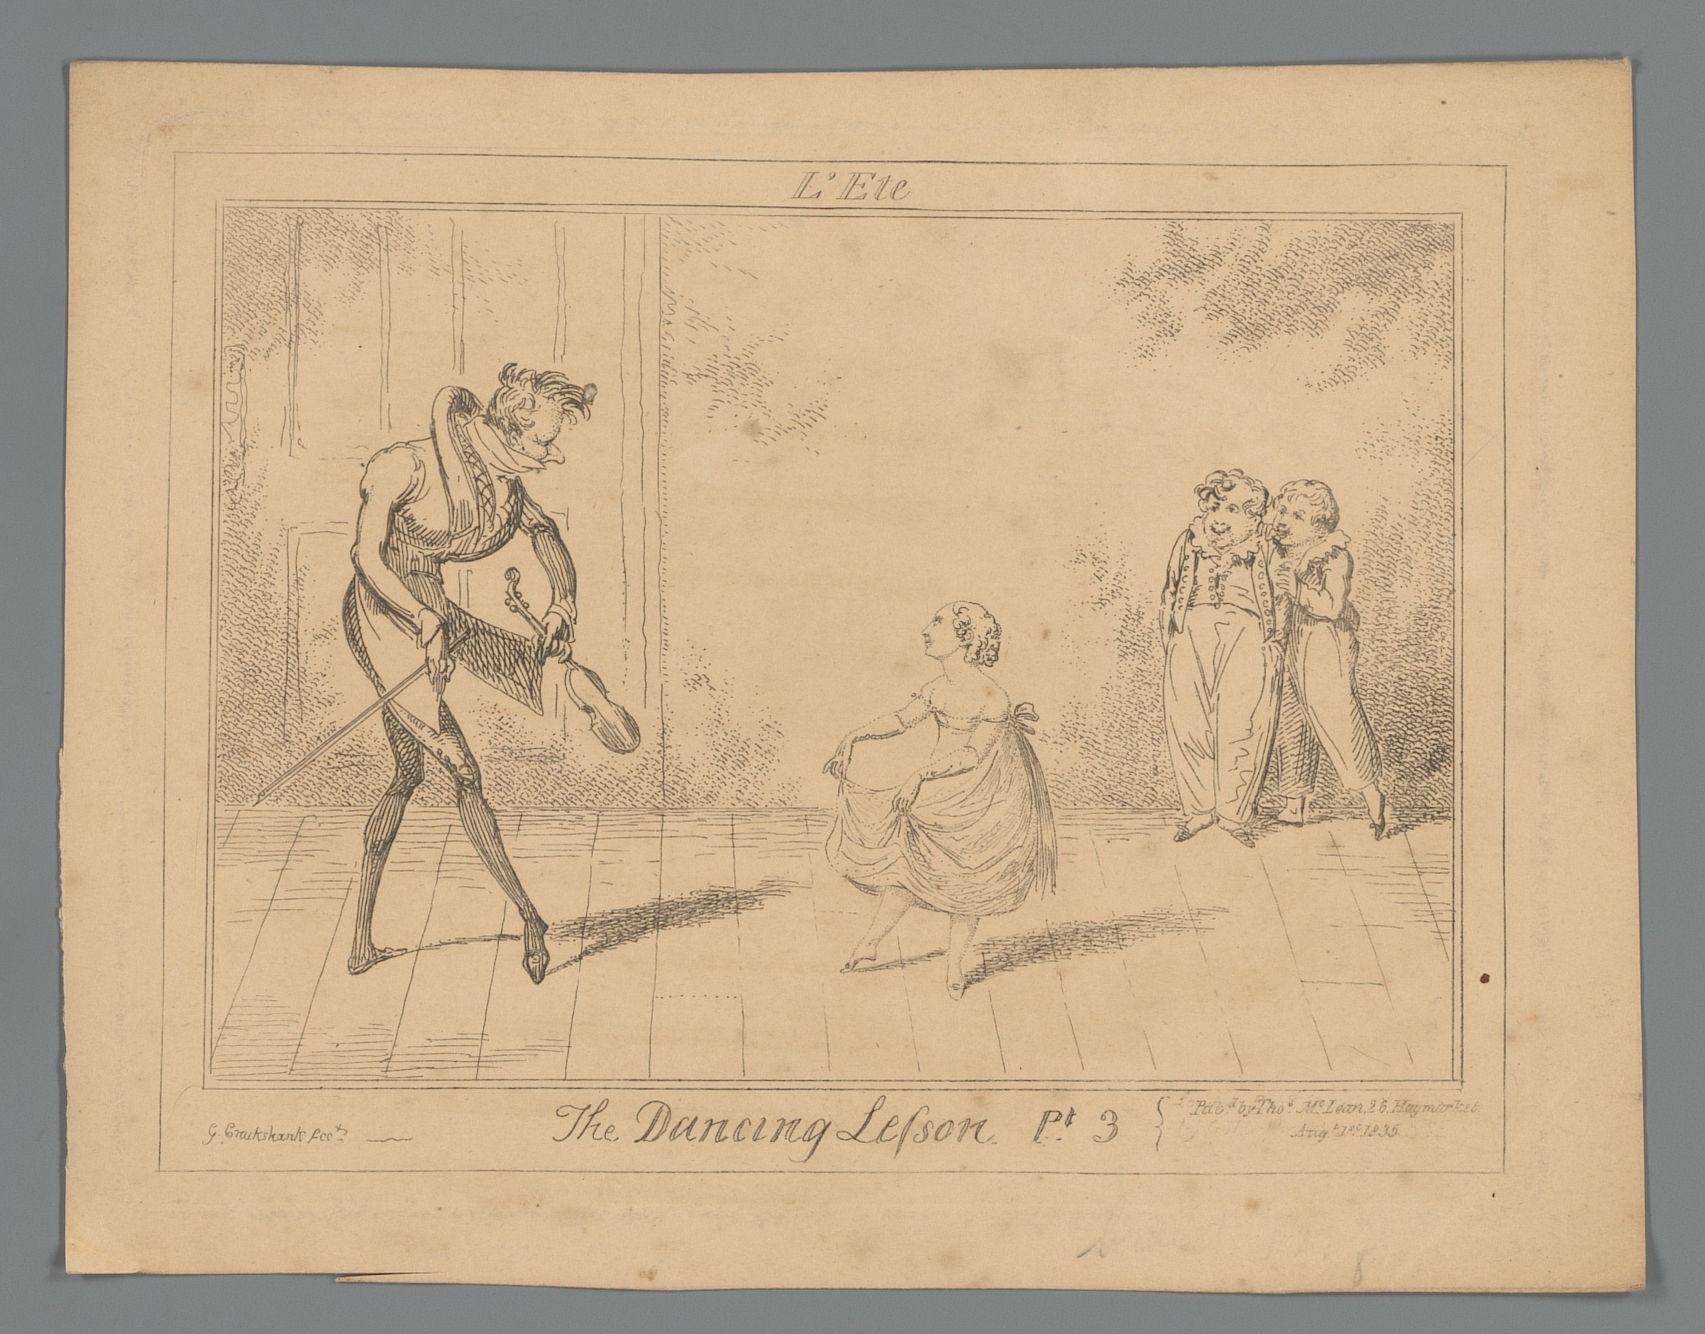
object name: print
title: Meisje op dansles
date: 1822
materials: paper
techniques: etching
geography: england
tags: woman dancing alone, political caricatures and satires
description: Dansles. Een jong meisje krijgt dansles van een dansmeester. Twee jongens kijken lachend toe. Uit een groep van vier platen.